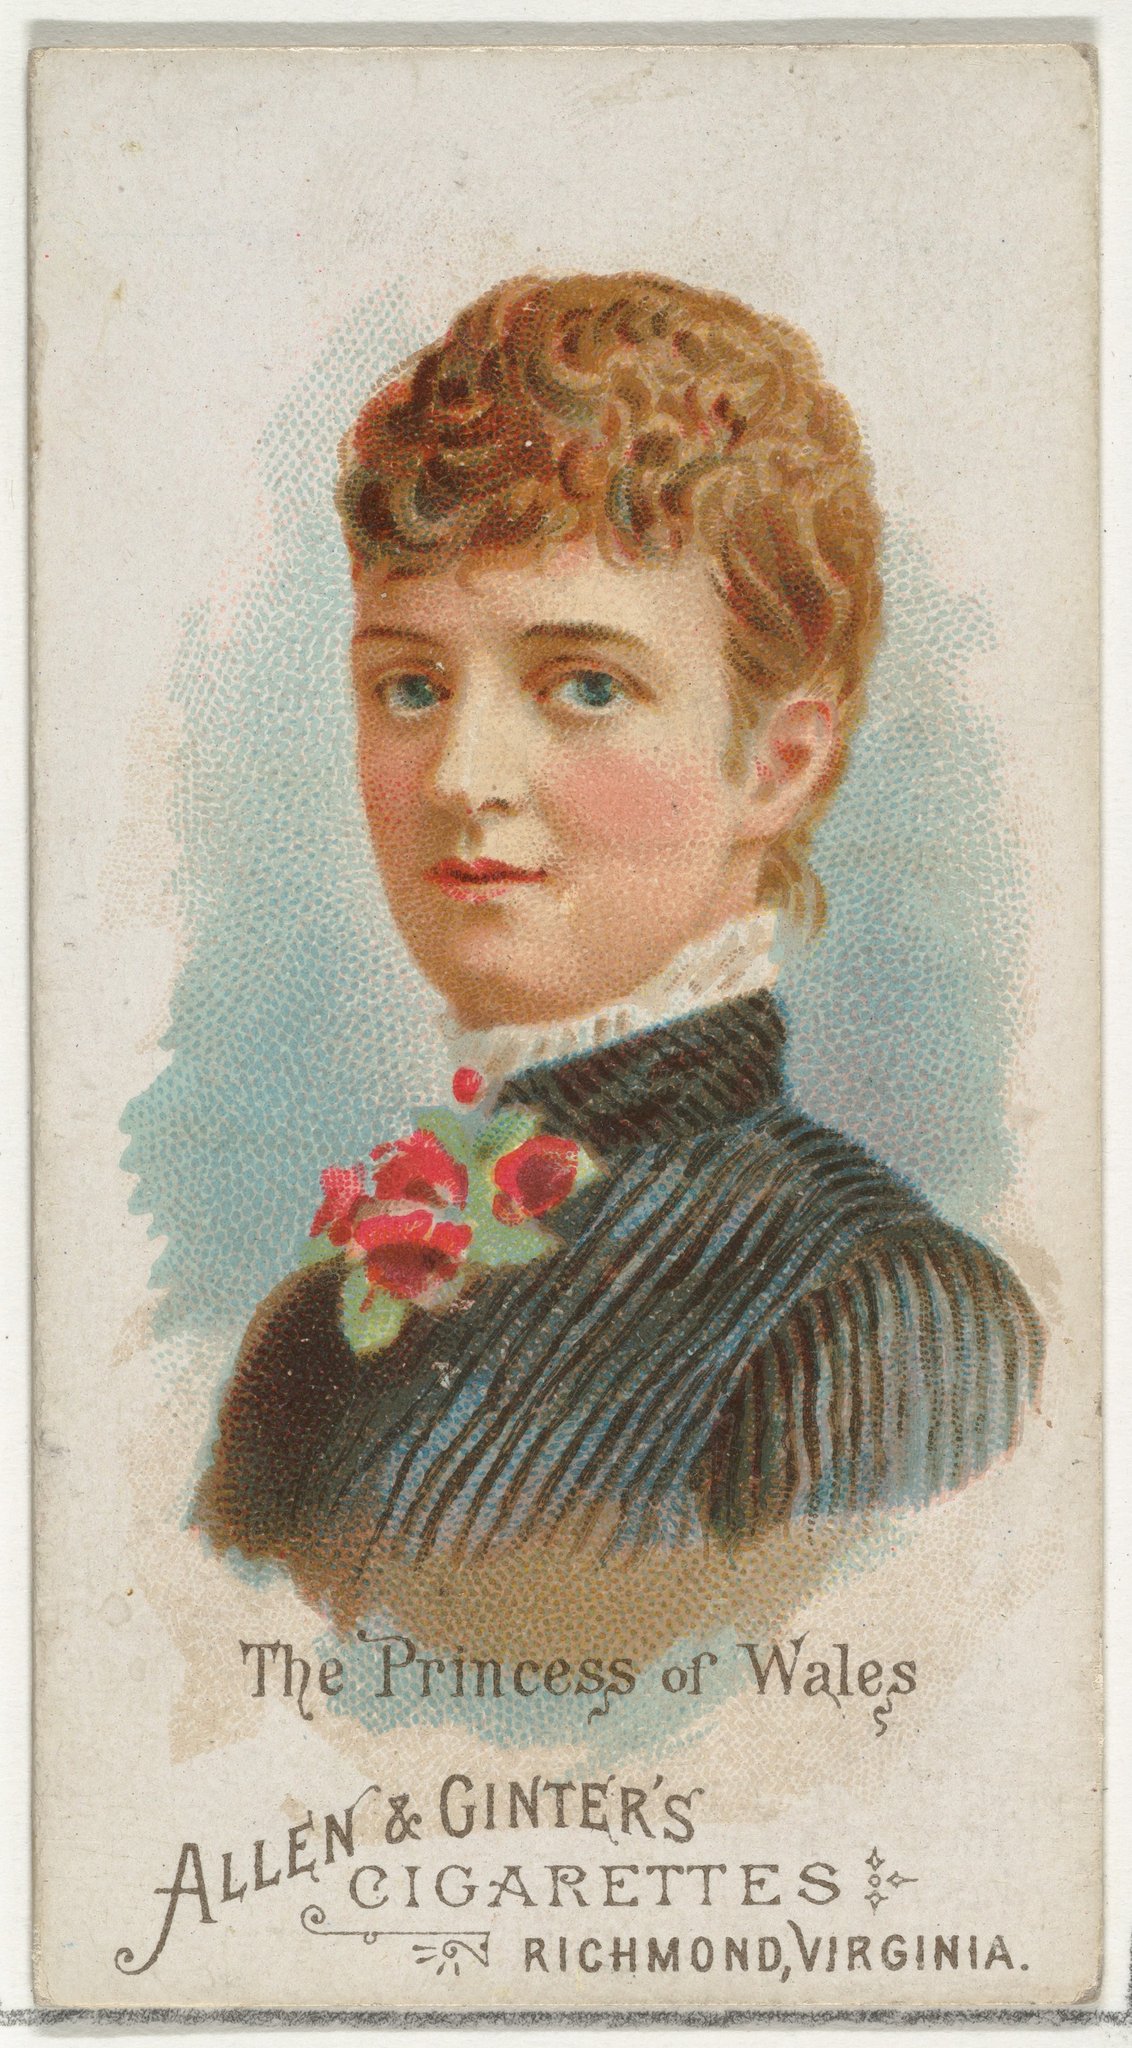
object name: print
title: The Princess of Wales, from World's Beauties, Series 1 (N26) for Allen & Ginter Cigarettes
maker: allen & ginter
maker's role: publisher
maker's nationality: american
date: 1888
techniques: color lithograph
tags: princesses,women